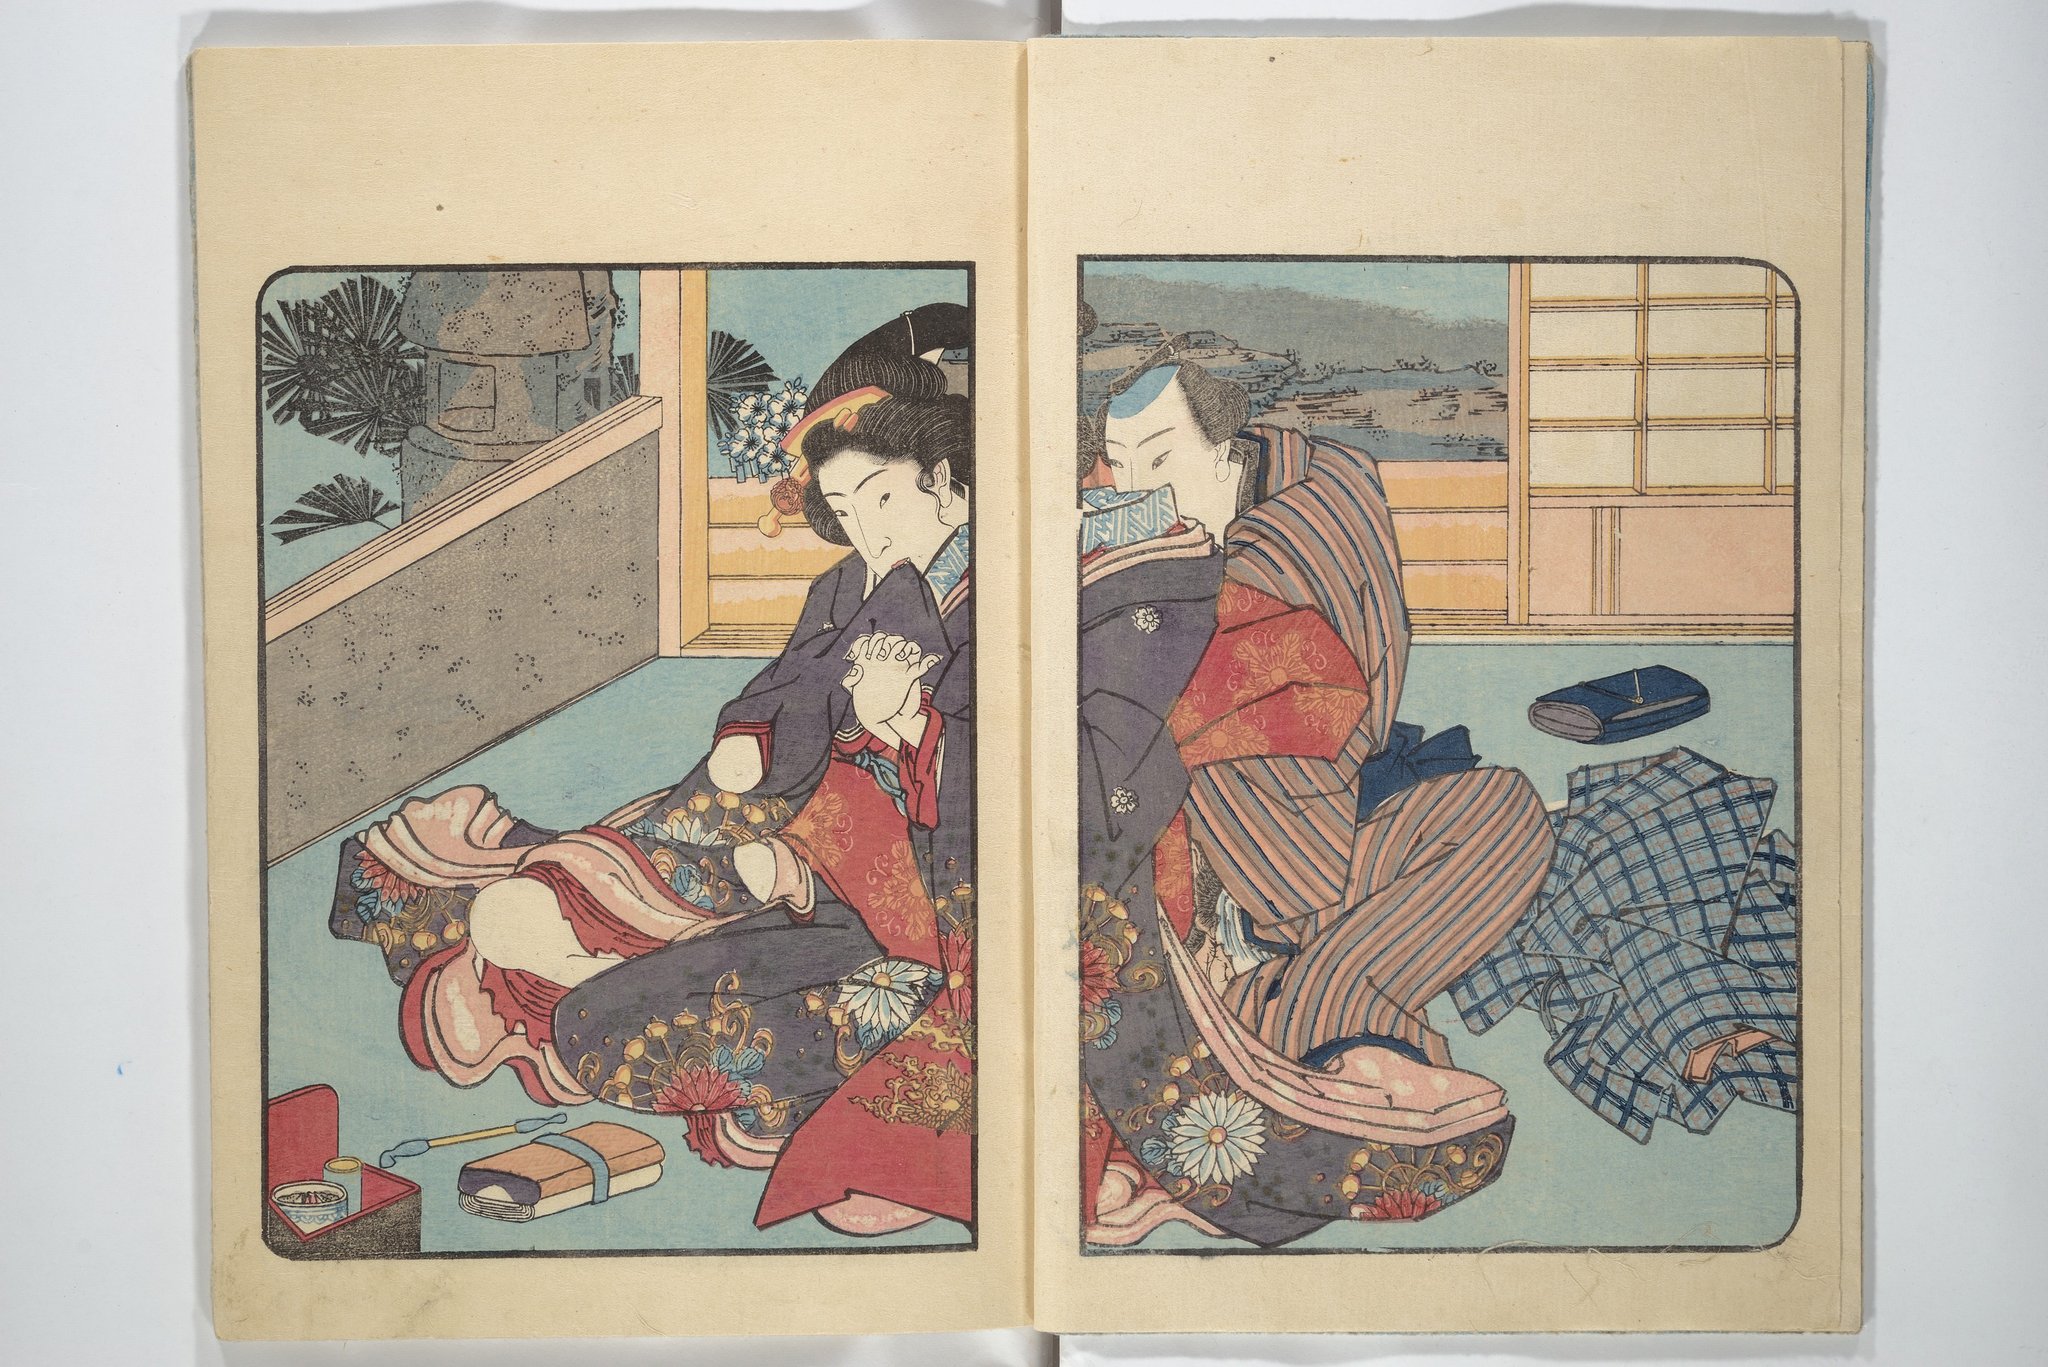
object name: illustrated book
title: Volume 3 of Unknown Erotic (Shunga) Set (Tōsei komonchō)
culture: japanese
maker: utagawa kuniyoshi 歌川國芳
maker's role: artist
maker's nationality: japanese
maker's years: 1797-1861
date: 1859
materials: ink, paper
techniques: woodblock print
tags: men,women